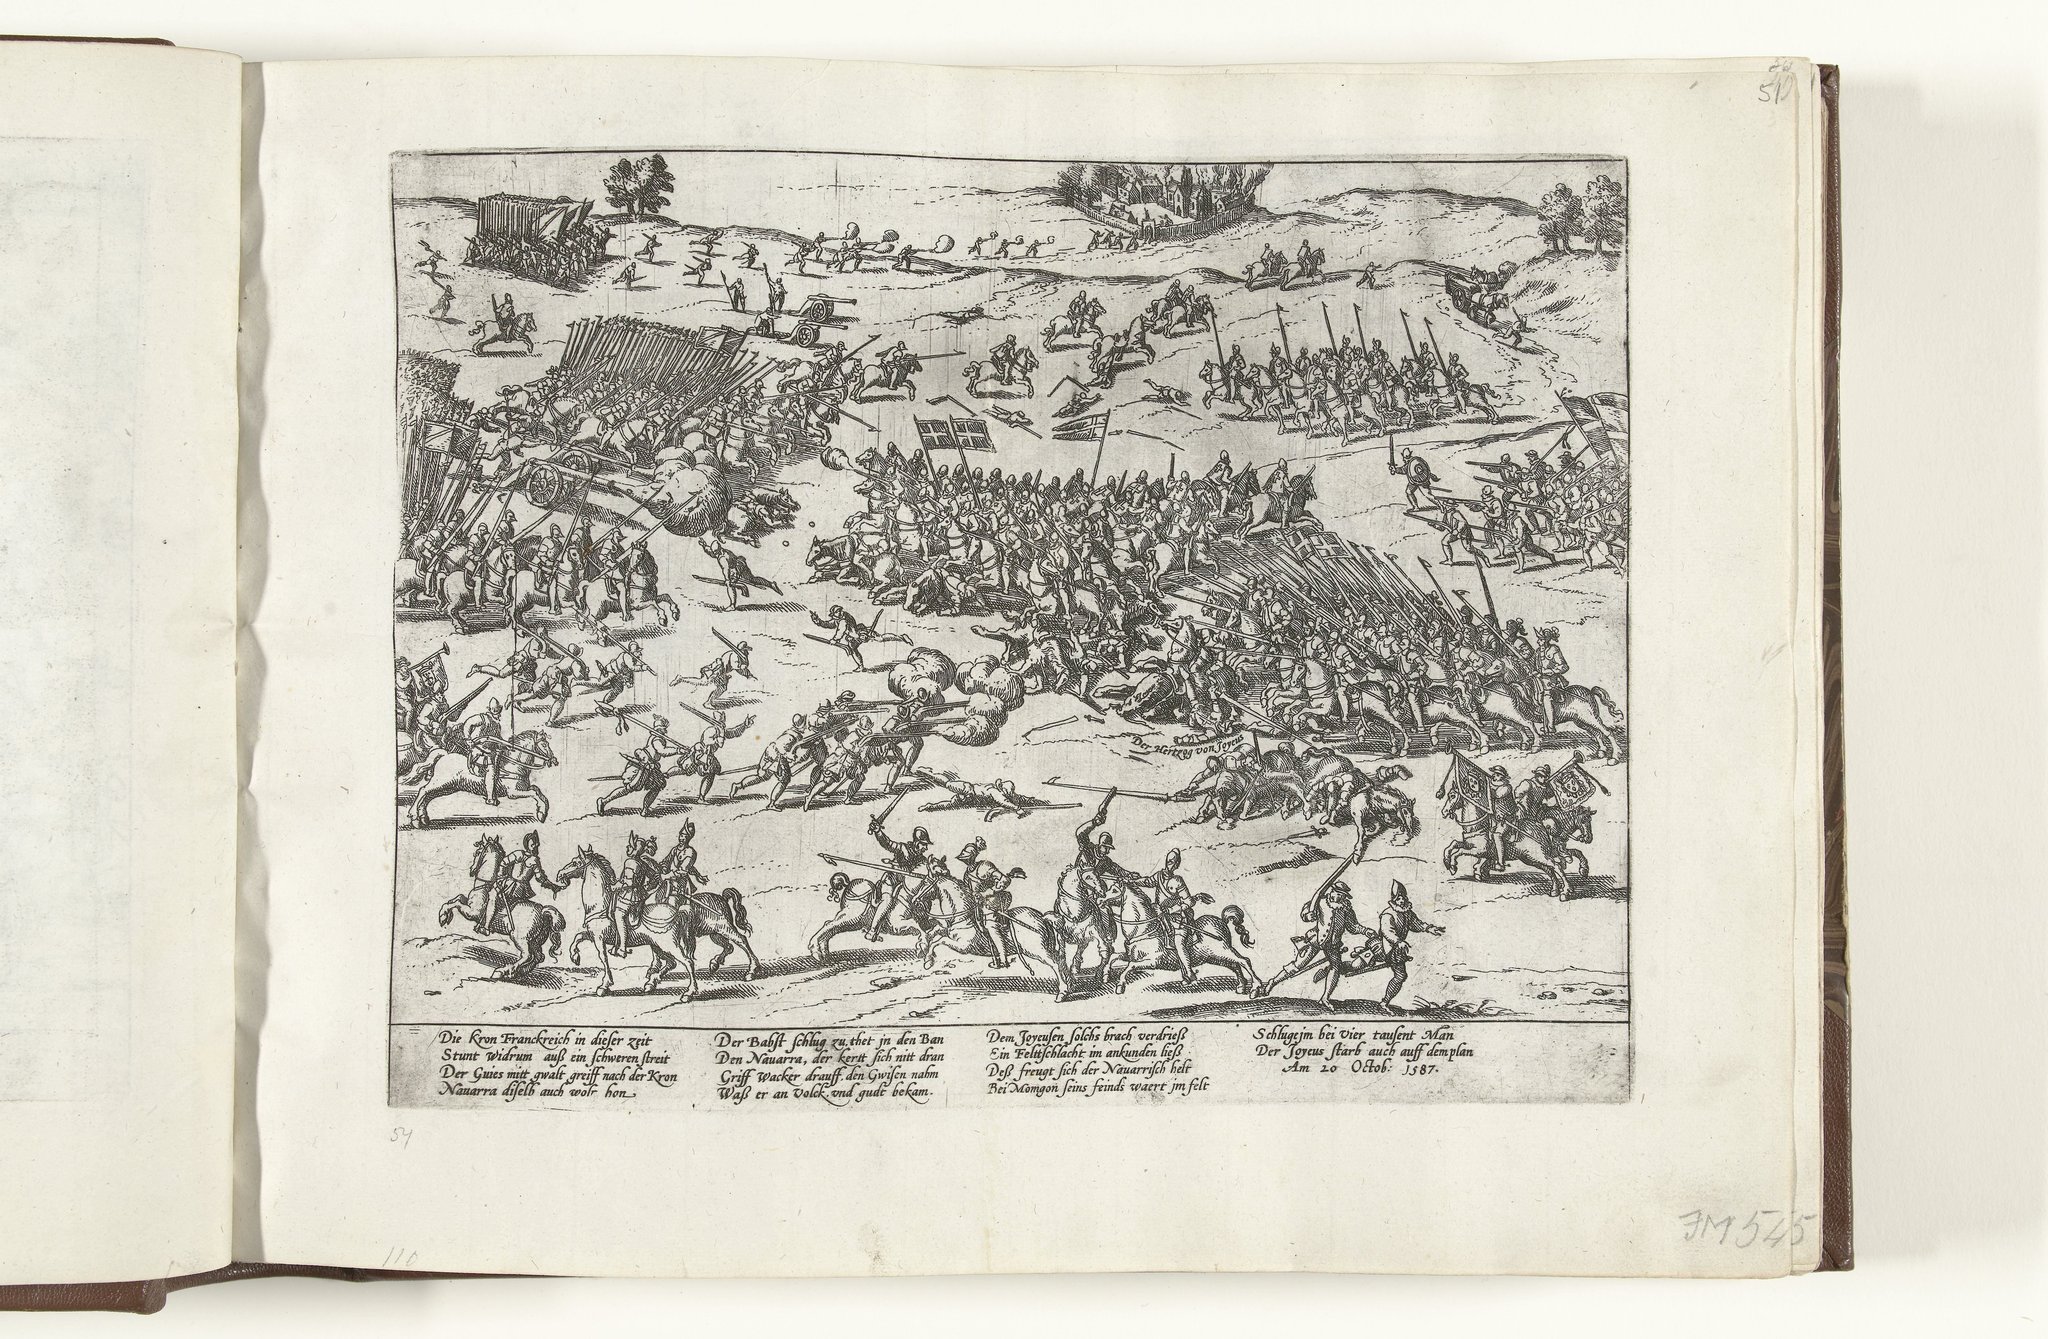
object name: print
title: Overwinning van Hendrik IV bij Montjoie, 1587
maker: frans hogenberg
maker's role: print maker, publisher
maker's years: 1538-1590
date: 1587-1589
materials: paper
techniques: etching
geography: cologne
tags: paris, hendrik iv (koning van frankrijk en navarra), battle (+ land forces)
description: Overwinning van koning Hendrik IV van Navarra bij Montjoie, 20 oktober 1587. Gezicht op de veldslag. Met onderschrift van 14 regels in het Duits. Ongenummerd.